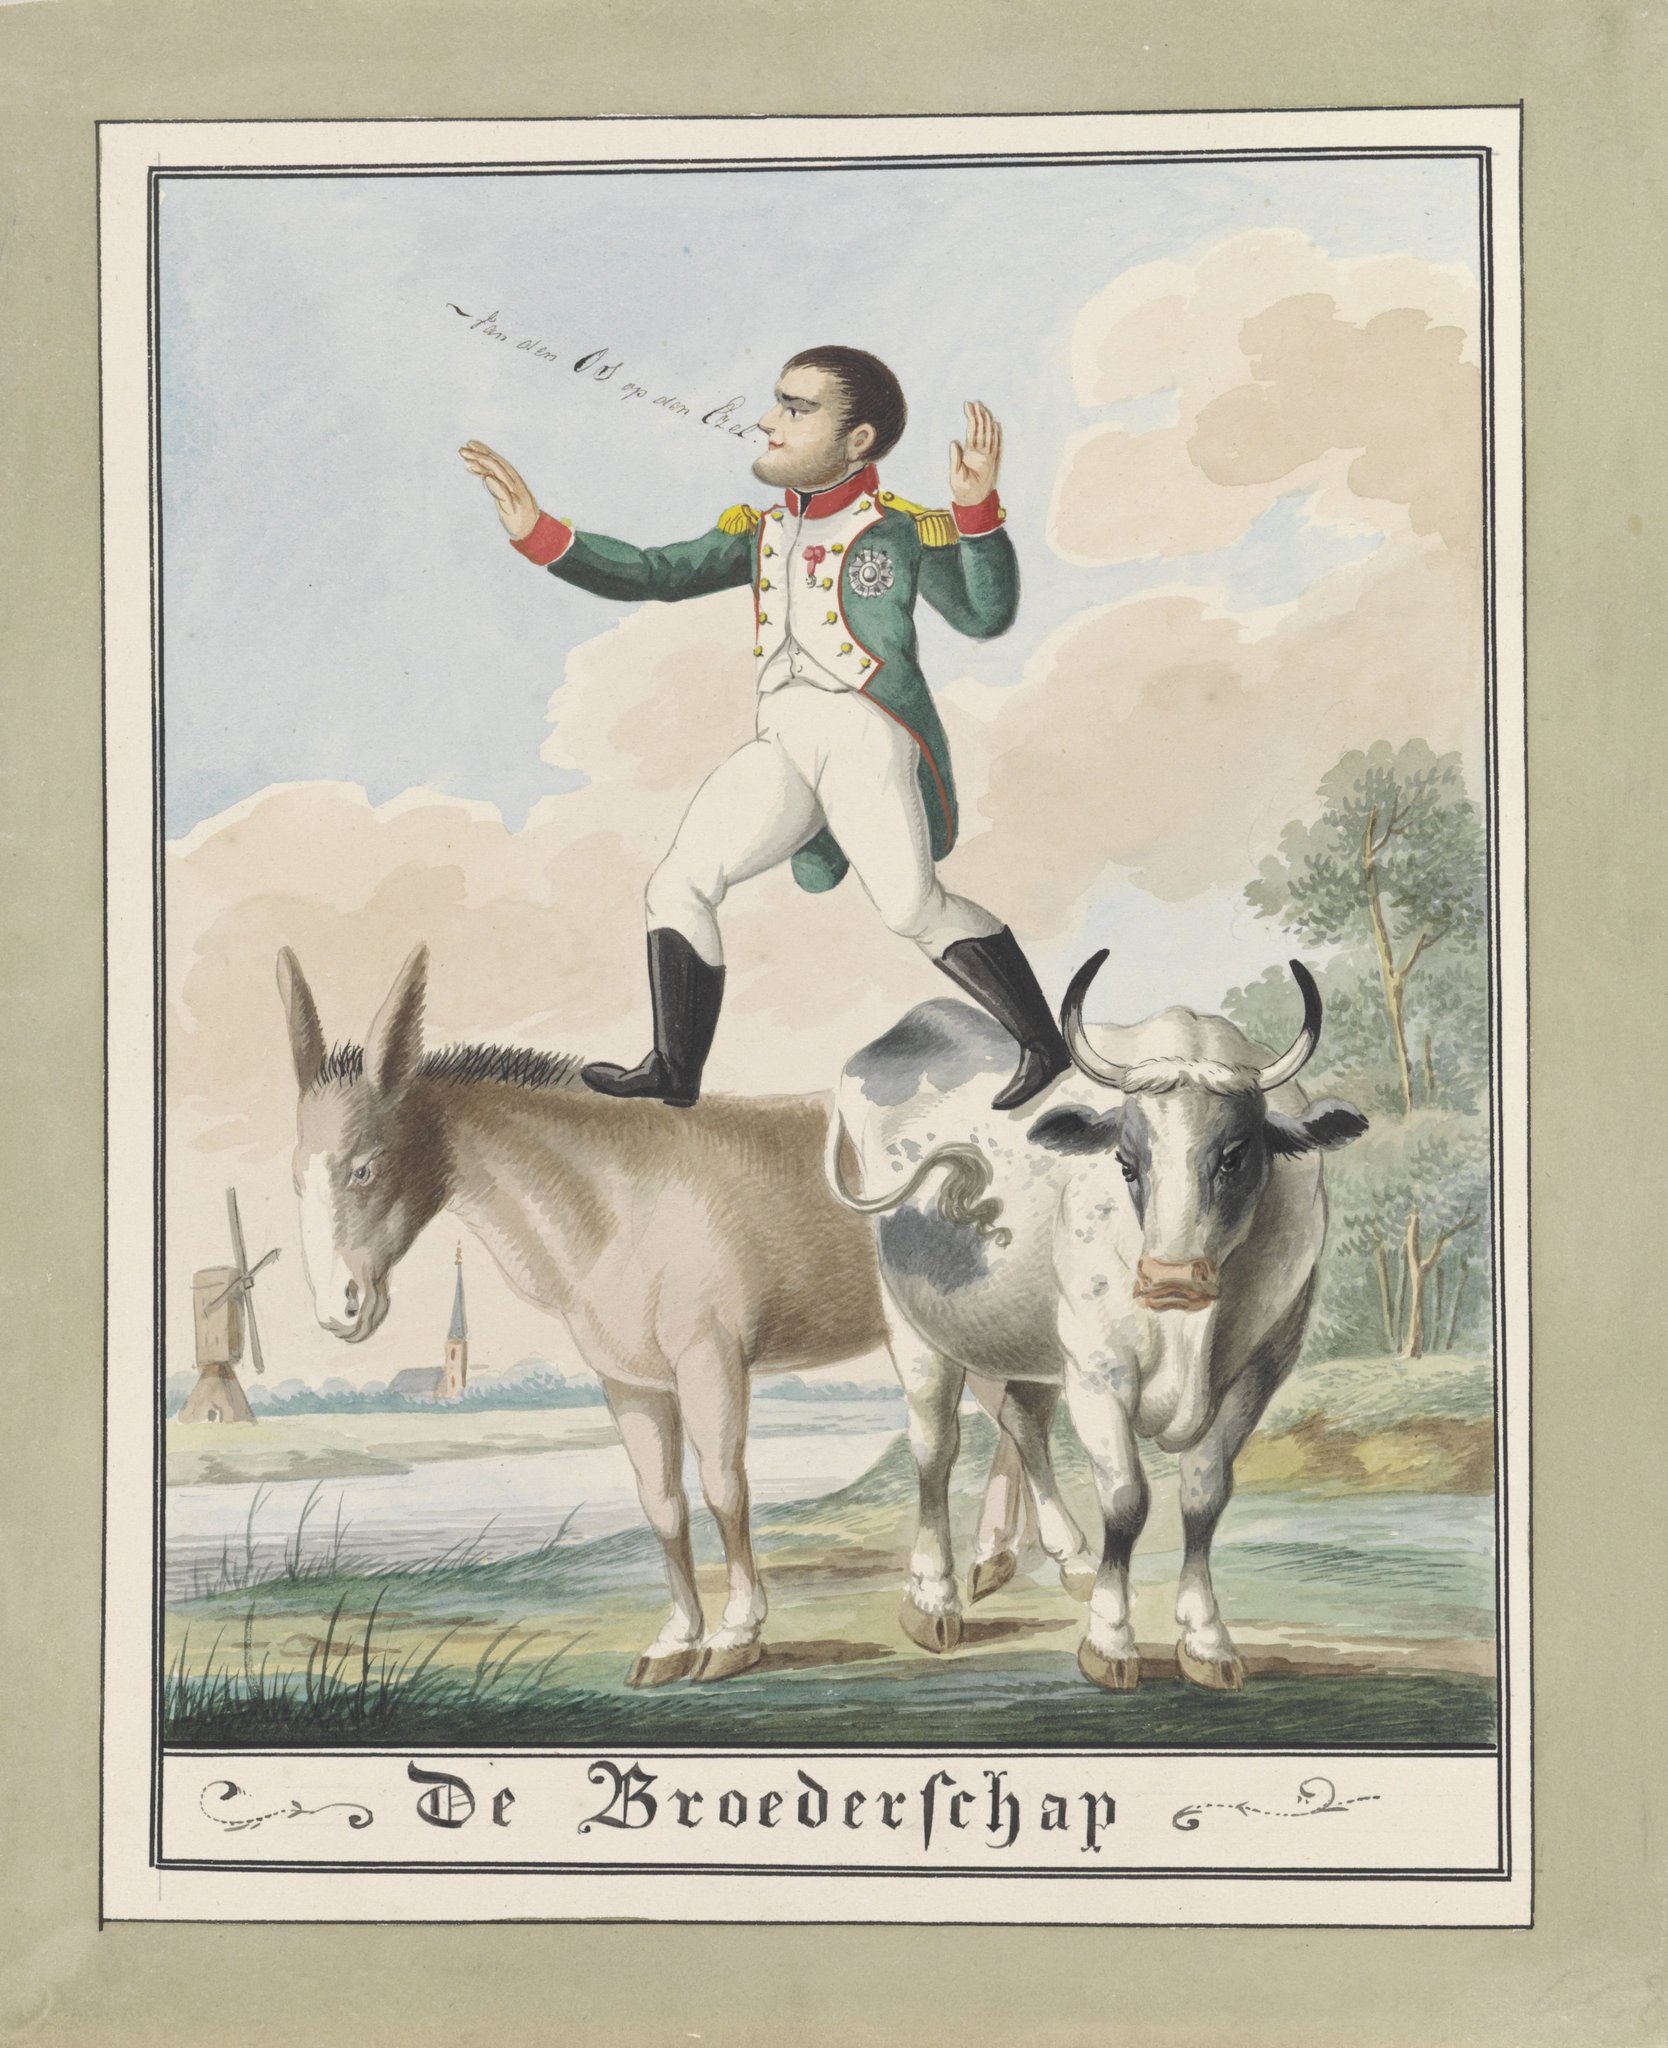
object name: drawing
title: Napoleon stapt van de os op de ezel, 1815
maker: wijnand esser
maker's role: draughtsman, print maker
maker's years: 1779-1860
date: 1815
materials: paper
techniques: brush, pen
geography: netherlands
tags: napoleon i (emperor of the french), bovine cattle, mule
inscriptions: collector's mark: Lugt 2228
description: Napoleon, staande met een been op een ezel, het andere op een os. Bij Napoleon het opschrift 'Van den Os op den Ezel'. Op de achtergrond een Hollands landschap. Spotprent op de val van Napoleon na de nederlaag bij Waterloo op 18 juni 1815.